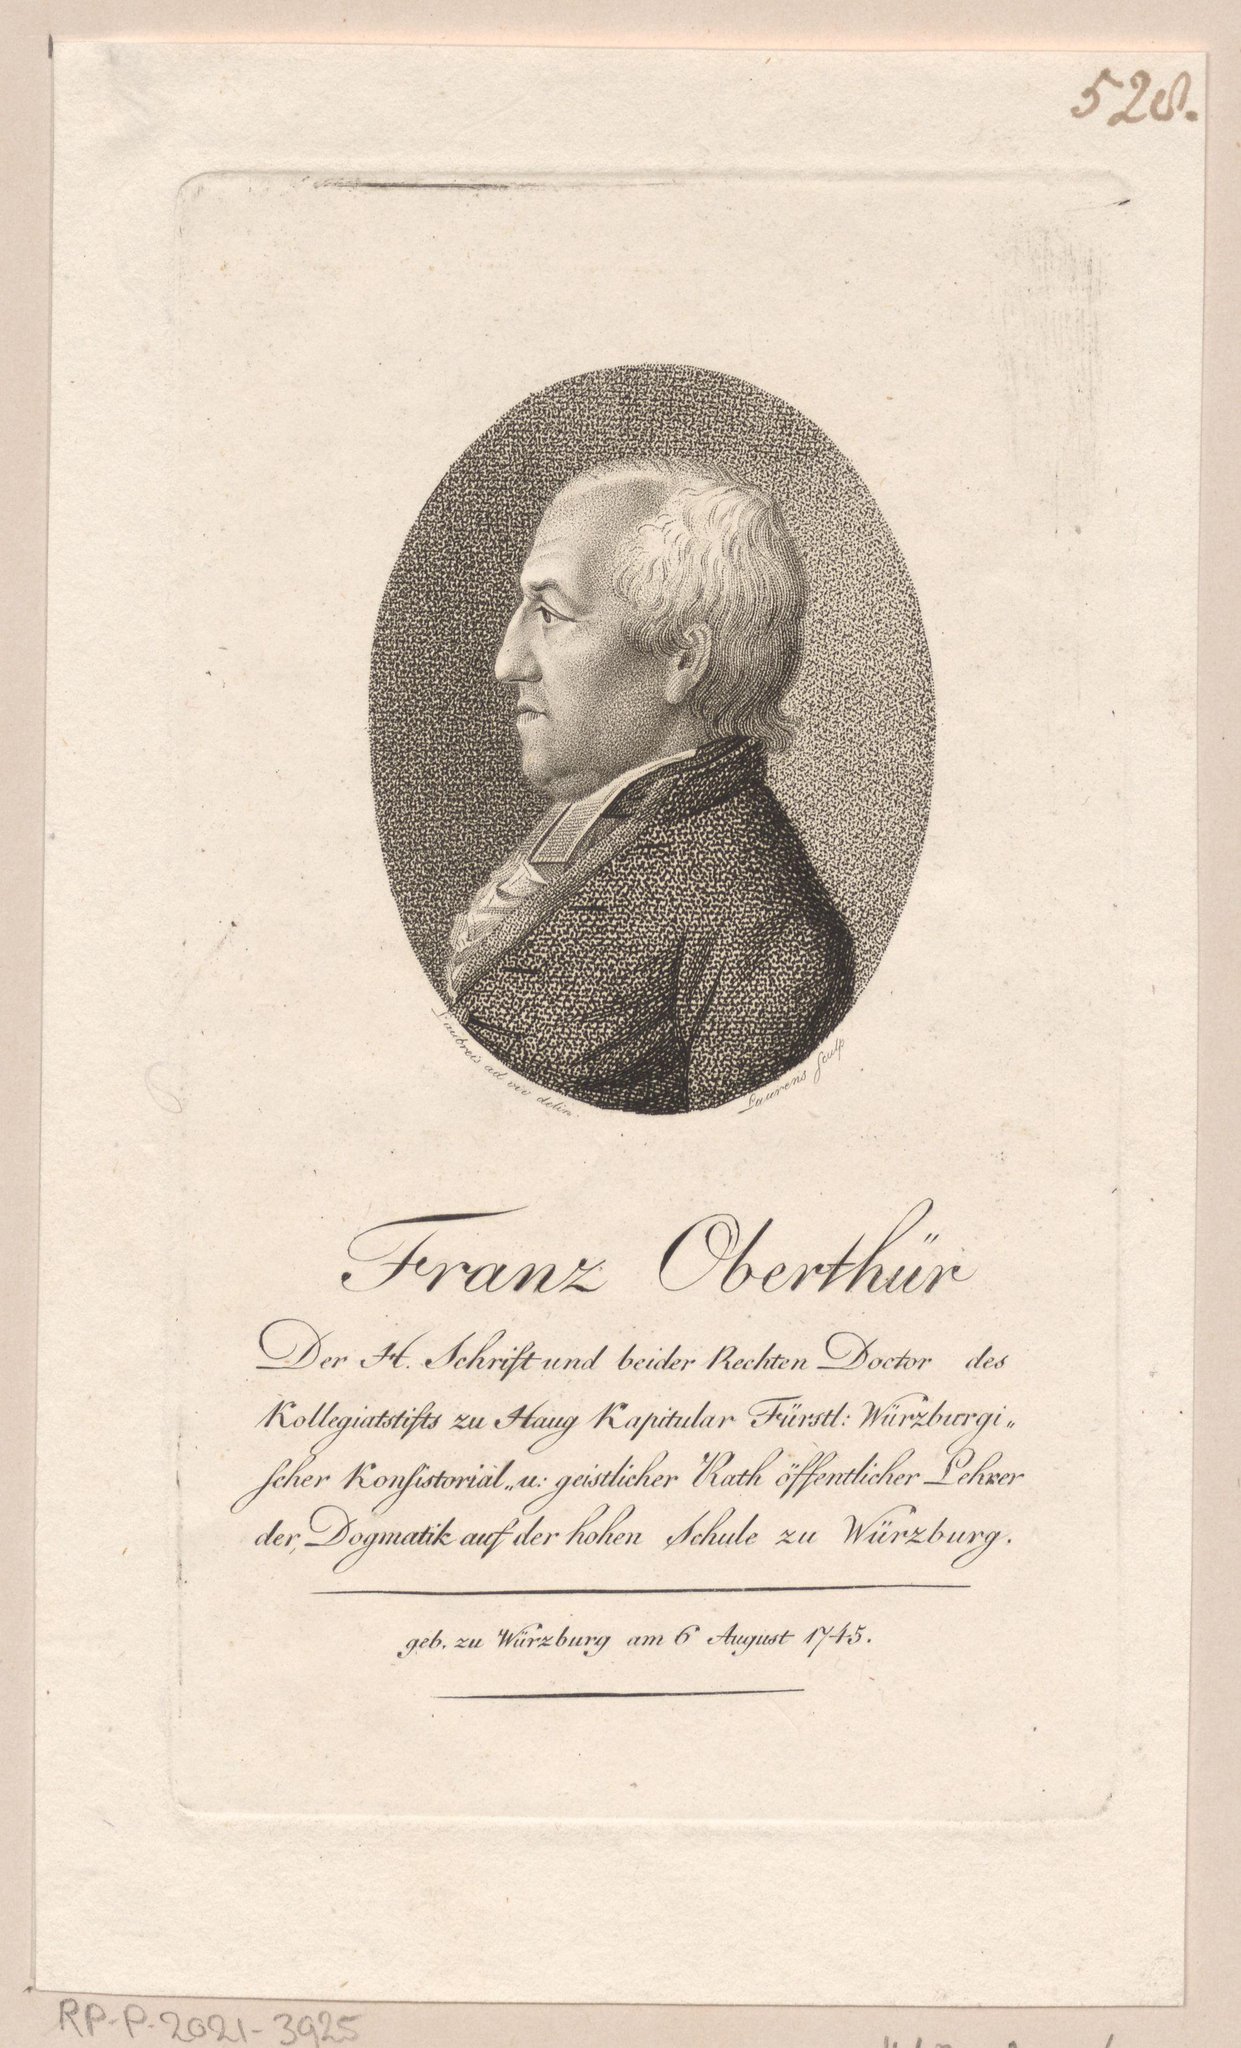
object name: print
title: Portret van Franz Oberthür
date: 1800-1831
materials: paper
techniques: stippling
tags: historical persons